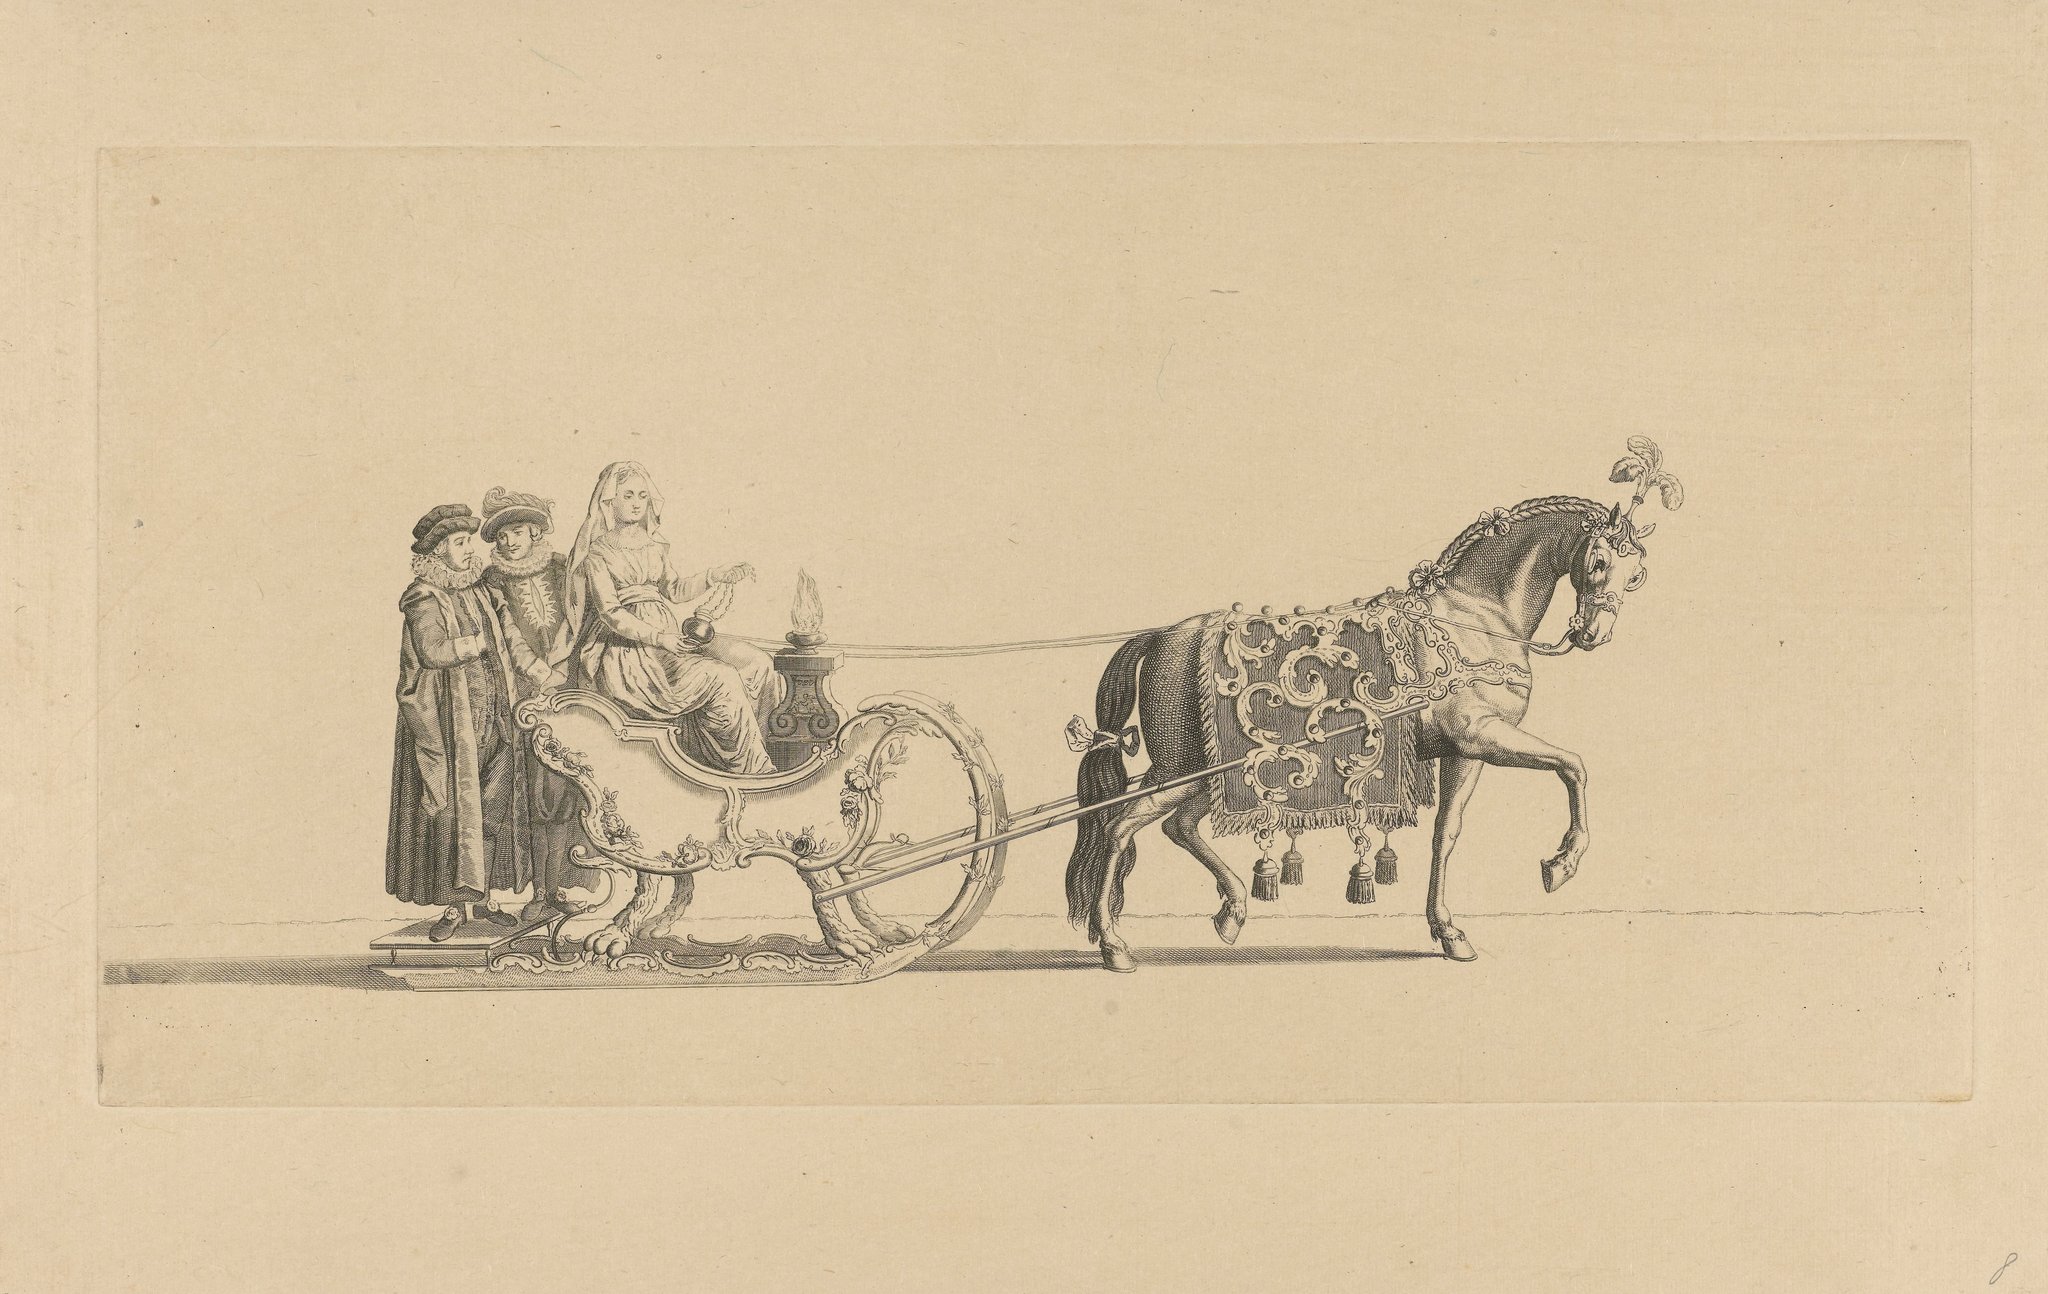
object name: print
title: Sledevaart van het Leidse genootschap Veniam Pro Laude in 1776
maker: nicolaas van der worm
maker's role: draughtsman, print maker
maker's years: 1757-1828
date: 1776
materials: paper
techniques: engraving, etching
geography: northern netherlands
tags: allegorical representations ~ religion; 'religione', 'religione de ss. mauritio e lazaro', 'religione vera christiana' (ripa), sledge, sleigh (winter sports), commemoration of the founding of a university, leiden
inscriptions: collector's mark: Lugt 240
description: De achtste slede in de optocht. Een slede met de personificatie van de Godsdienst, getrokken door een paard. Onderdeel van een reeks van twaalf platen (vóór het nummer en op ander papier) van de sledevaart op 24 januari 1776 georganiseerd door het Leidse genootschap Veniam Pro Laude bij gelegenheid van het Tweede Eeuwfeest van het Leids Ontzet (3 oktober 1574) en de oprichting van de Universiteit van Leiden (8 februari 1575).